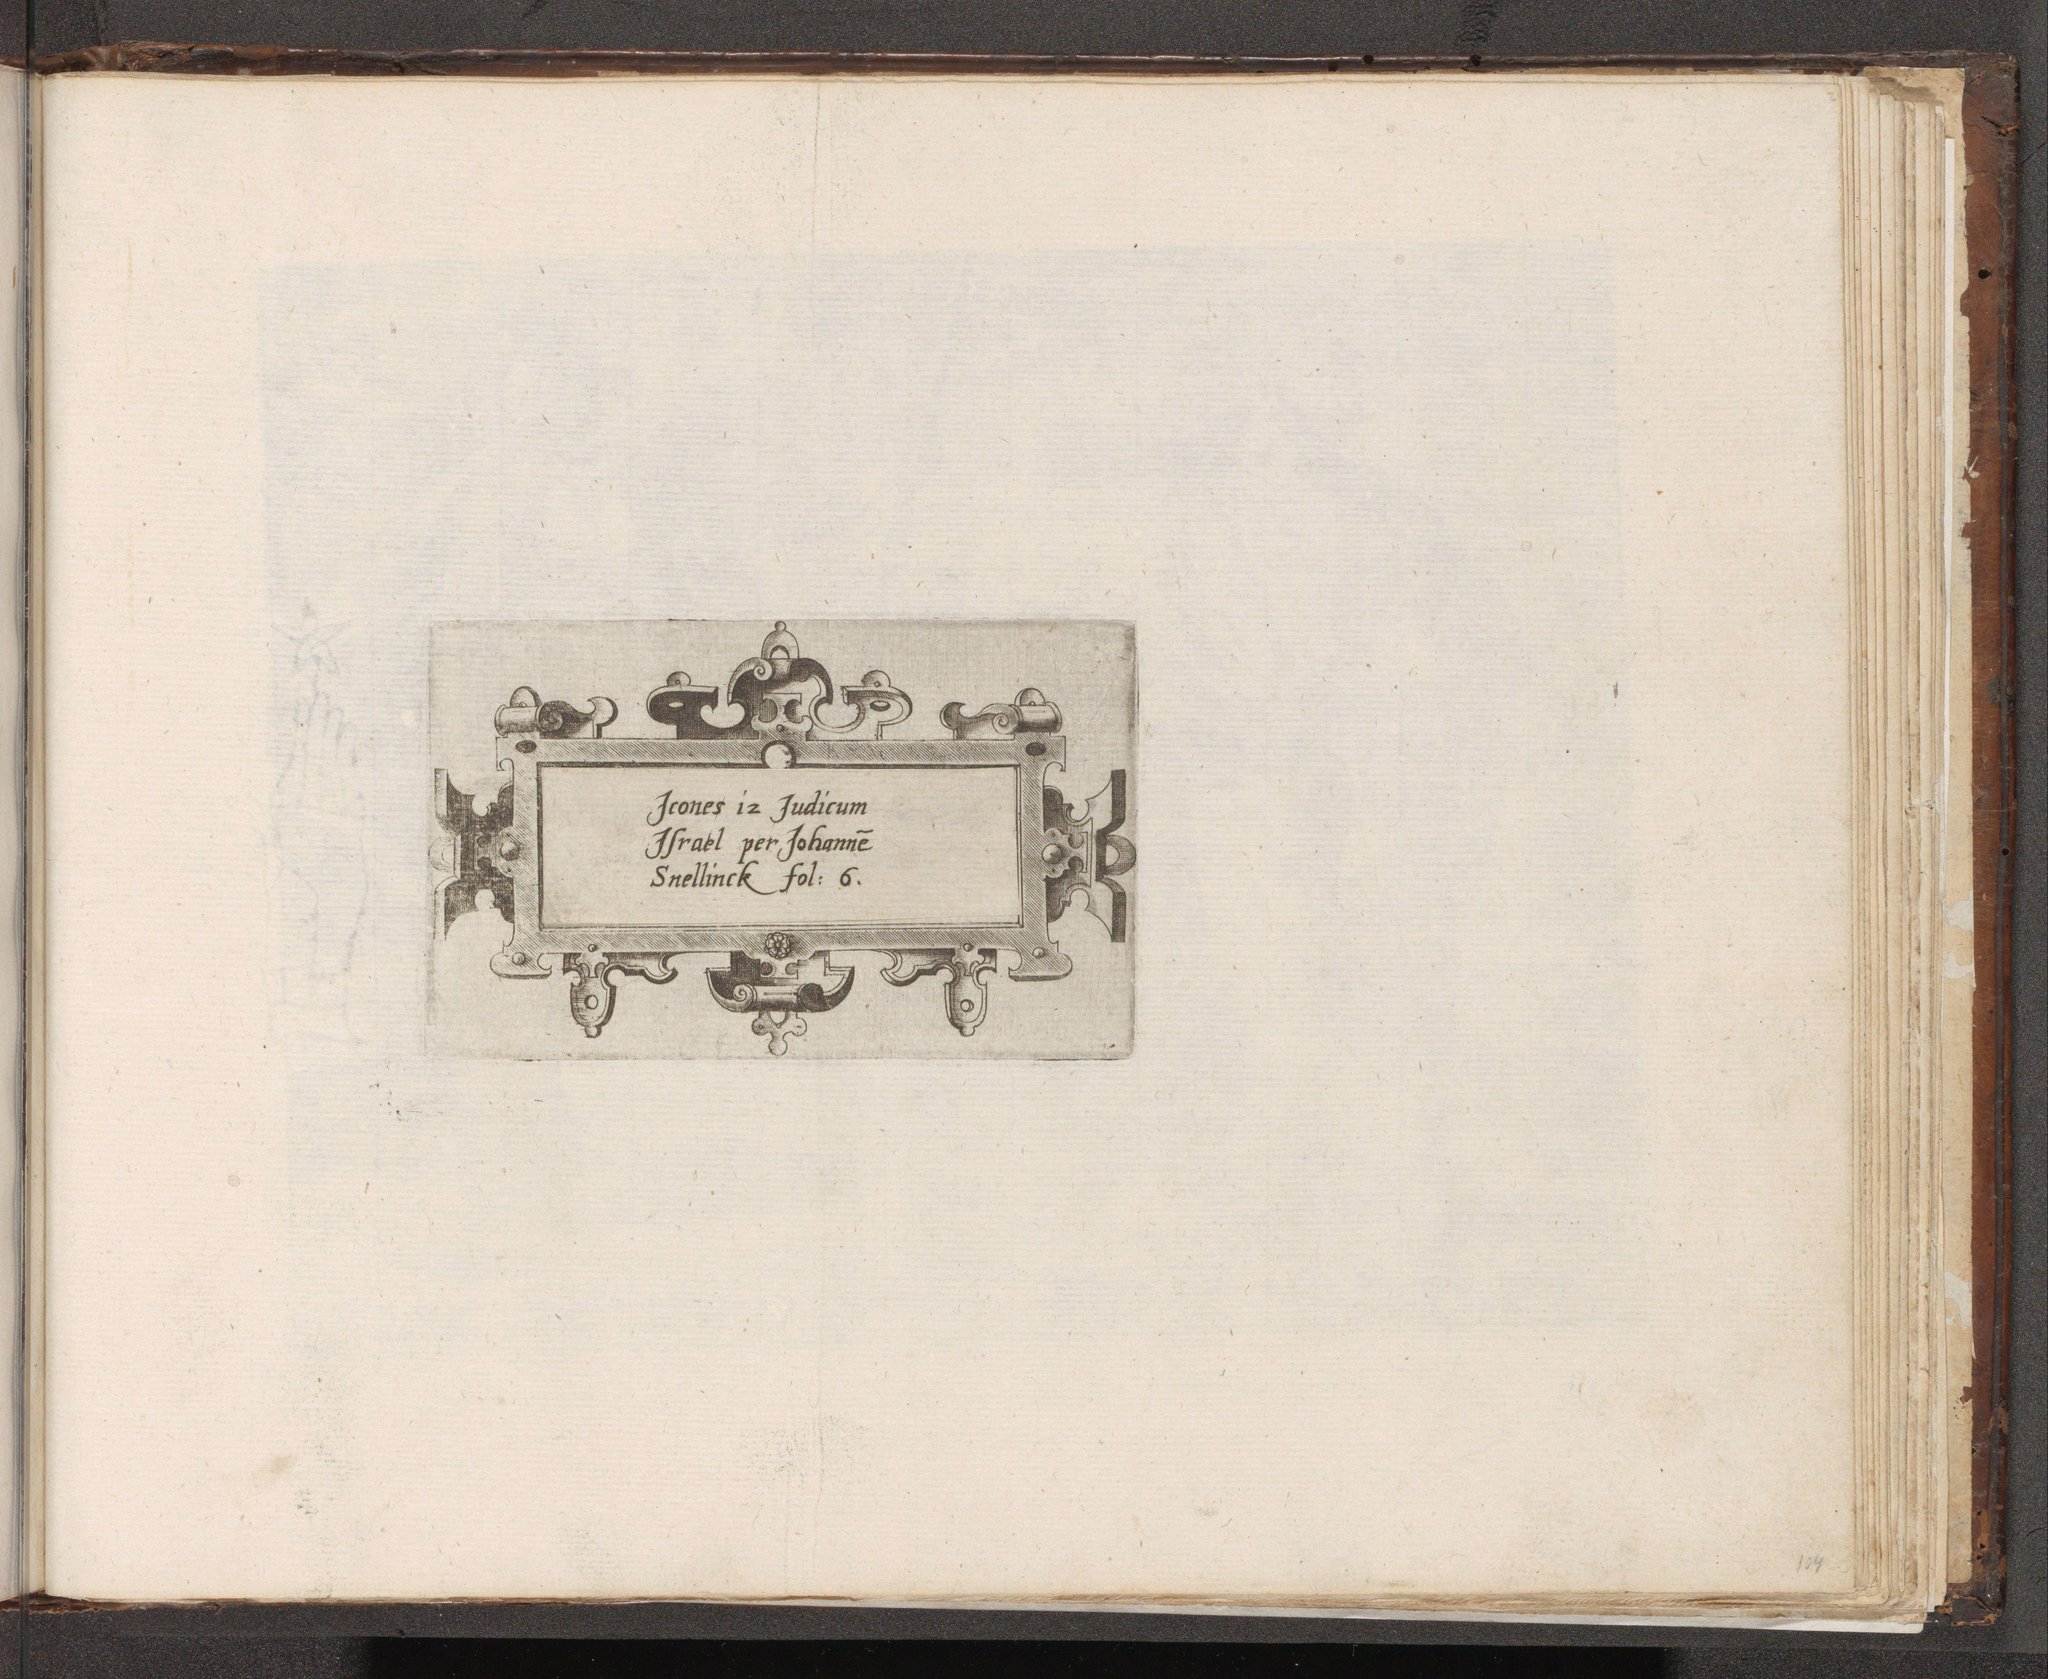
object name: album leaf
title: Cartouche met rolwerk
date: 1579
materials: paper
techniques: engraving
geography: antwerp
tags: scrollwork, strapwork ~ ornament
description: Titel in cartouche met rolwerk. Titelprent voor een serie prenten met voorstellingen van de twaalf rechters van Israël. Prent maakt deel uit van een album.